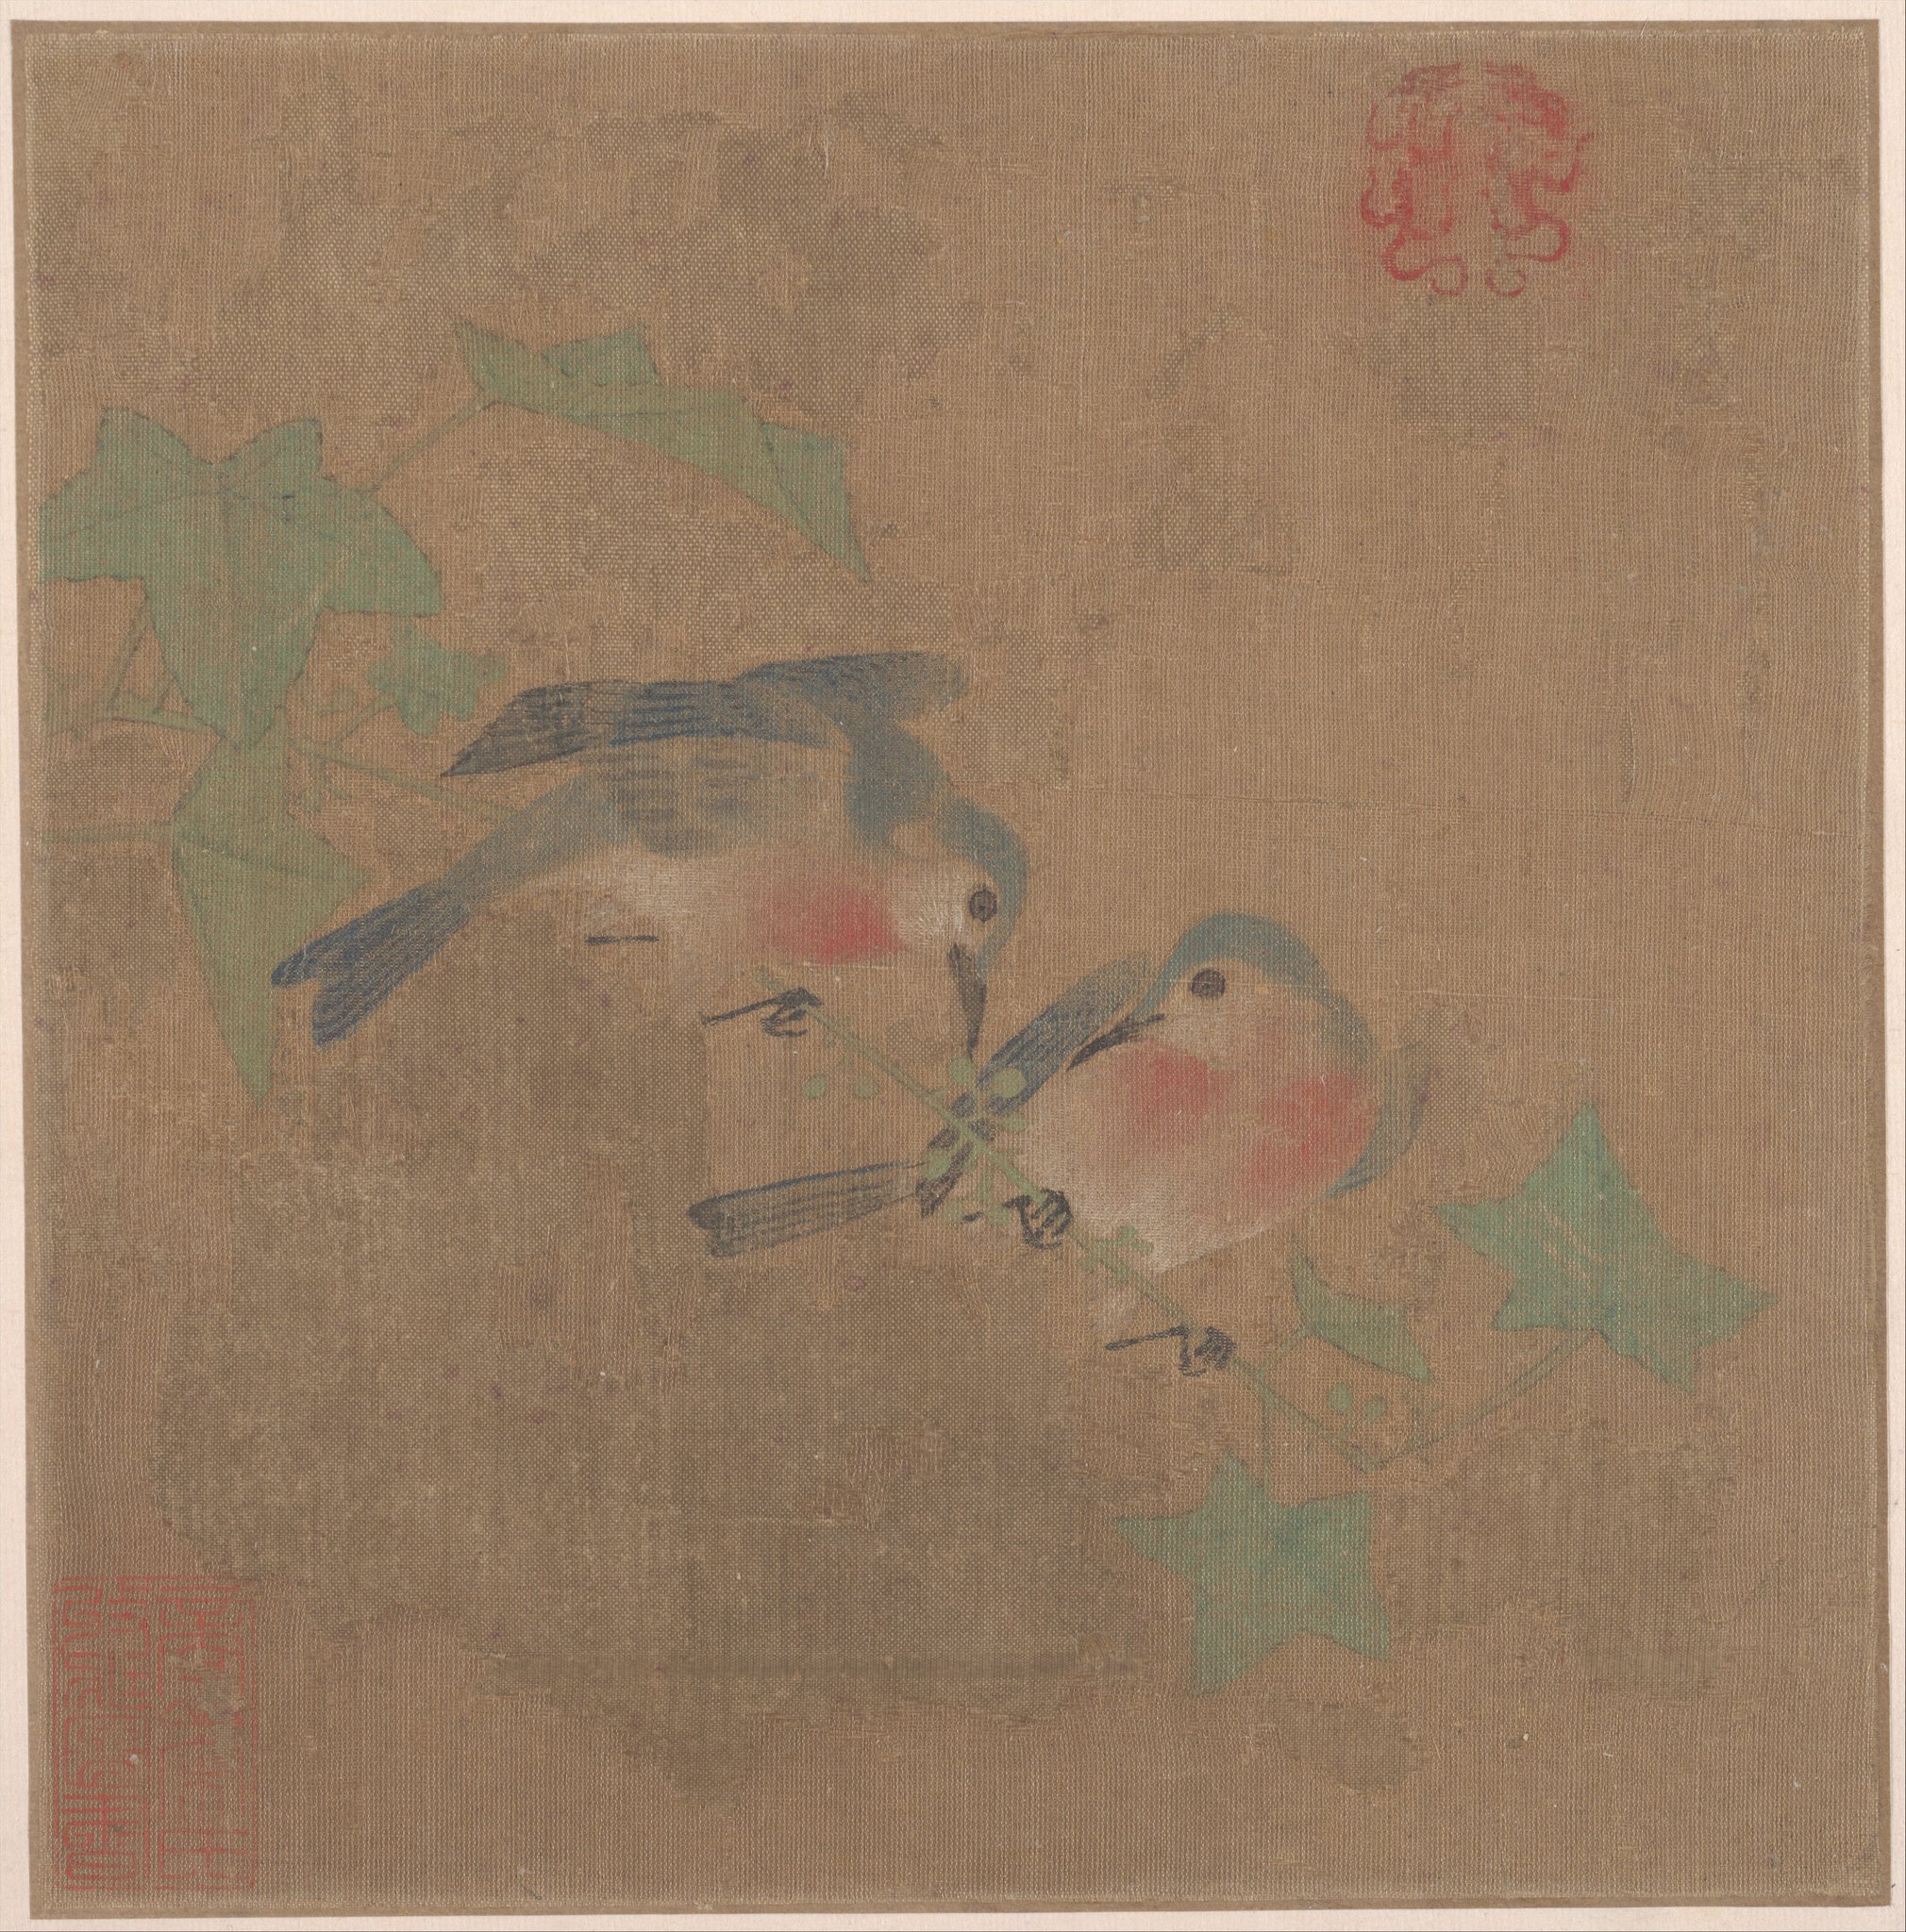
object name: album leaf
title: Birds on Fruit Branch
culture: chinese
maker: unidentified artist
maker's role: artist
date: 960-1279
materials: ink, silk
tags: birds